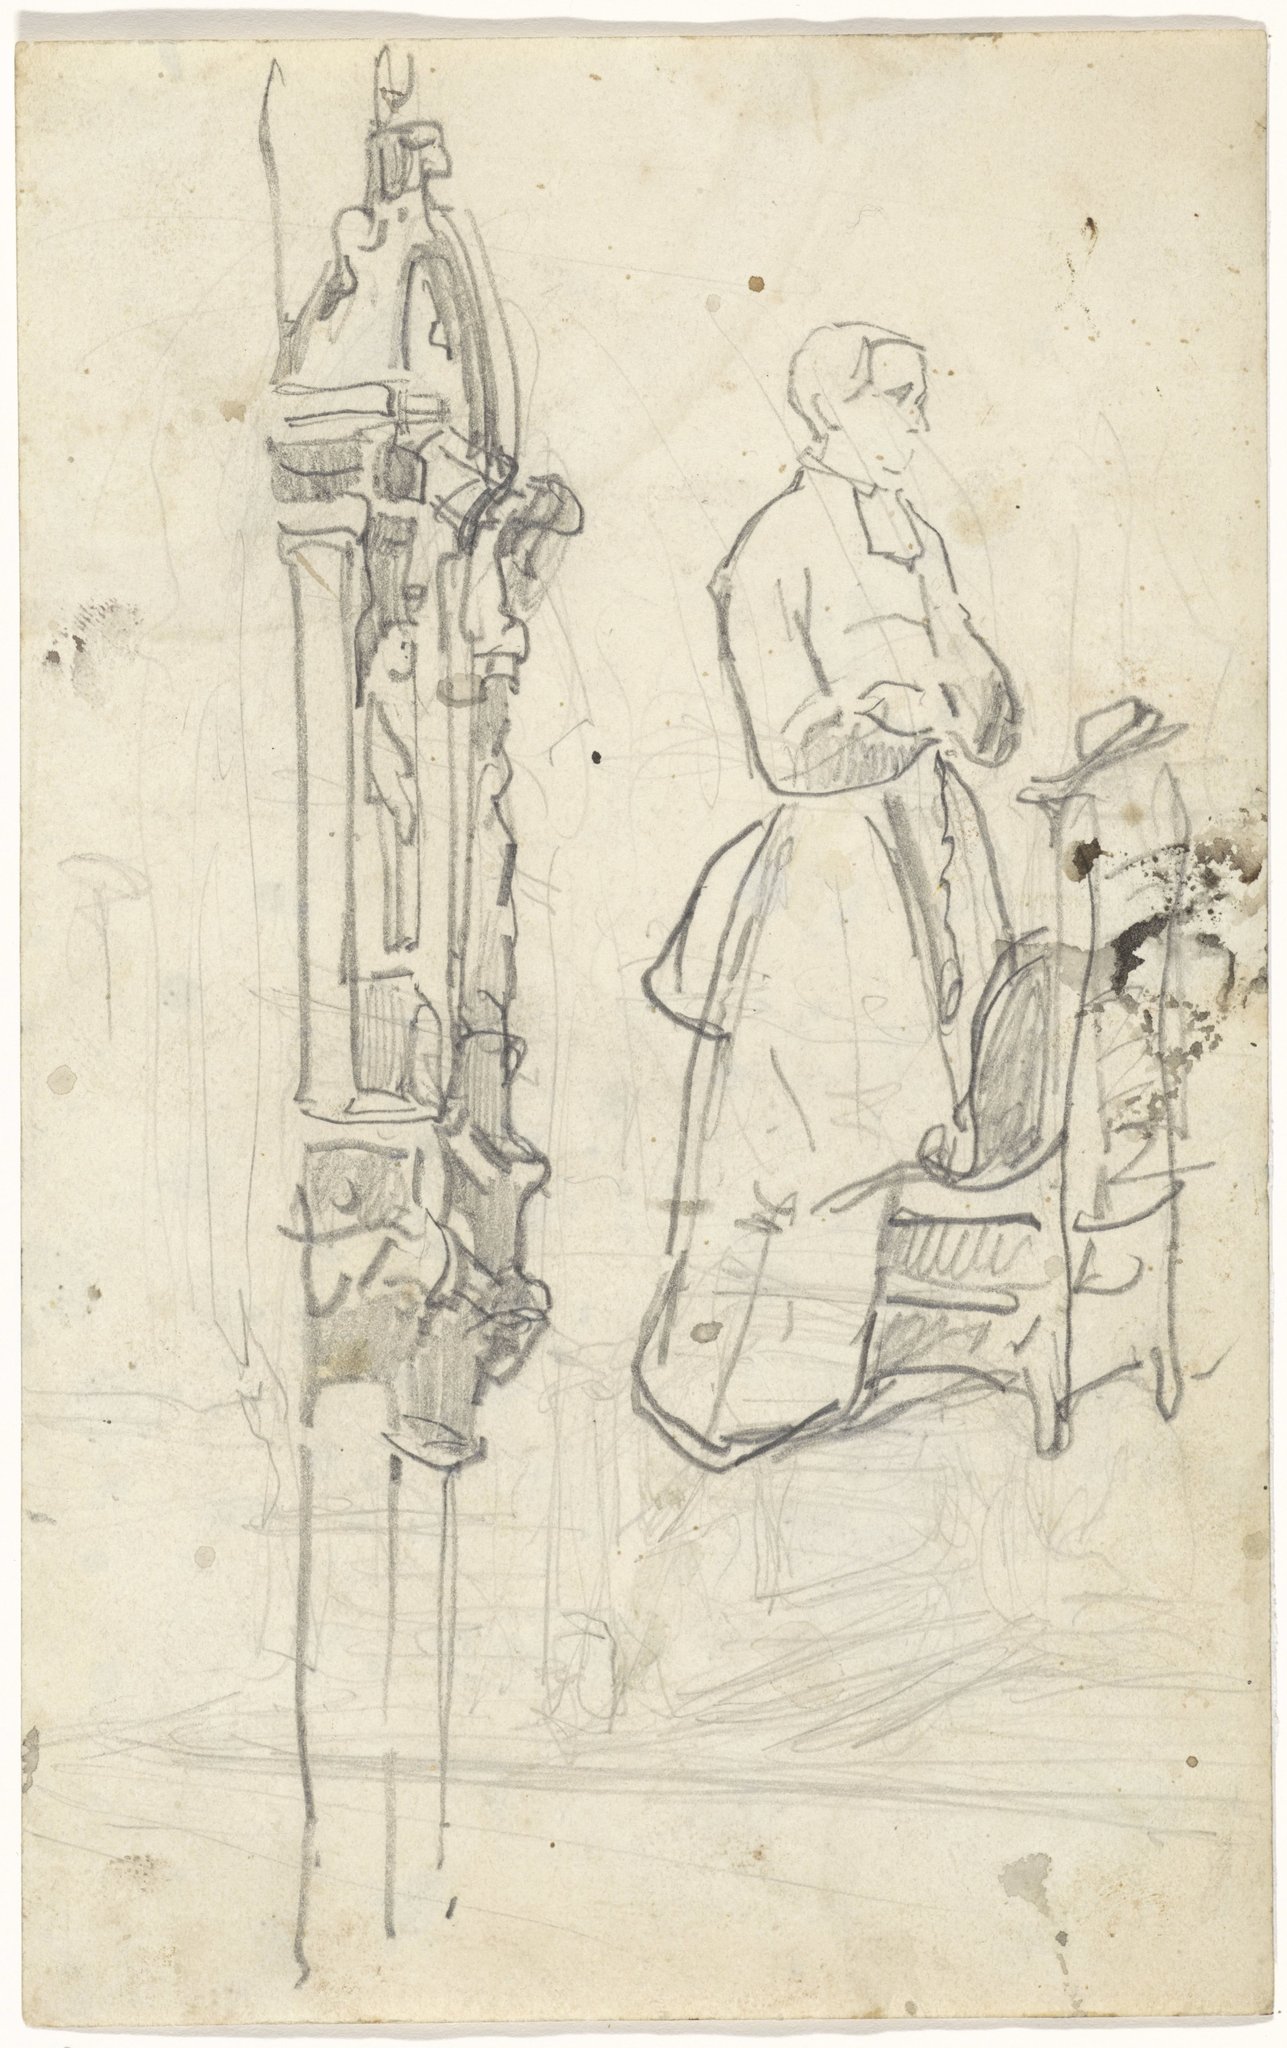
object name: schetsblad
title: Studies van een epitaaf en een geestelijke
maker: johannes bosboom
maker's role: draughtsman, painter, print maker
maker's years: 1817-1891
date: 1827-1891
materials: paper, pencil